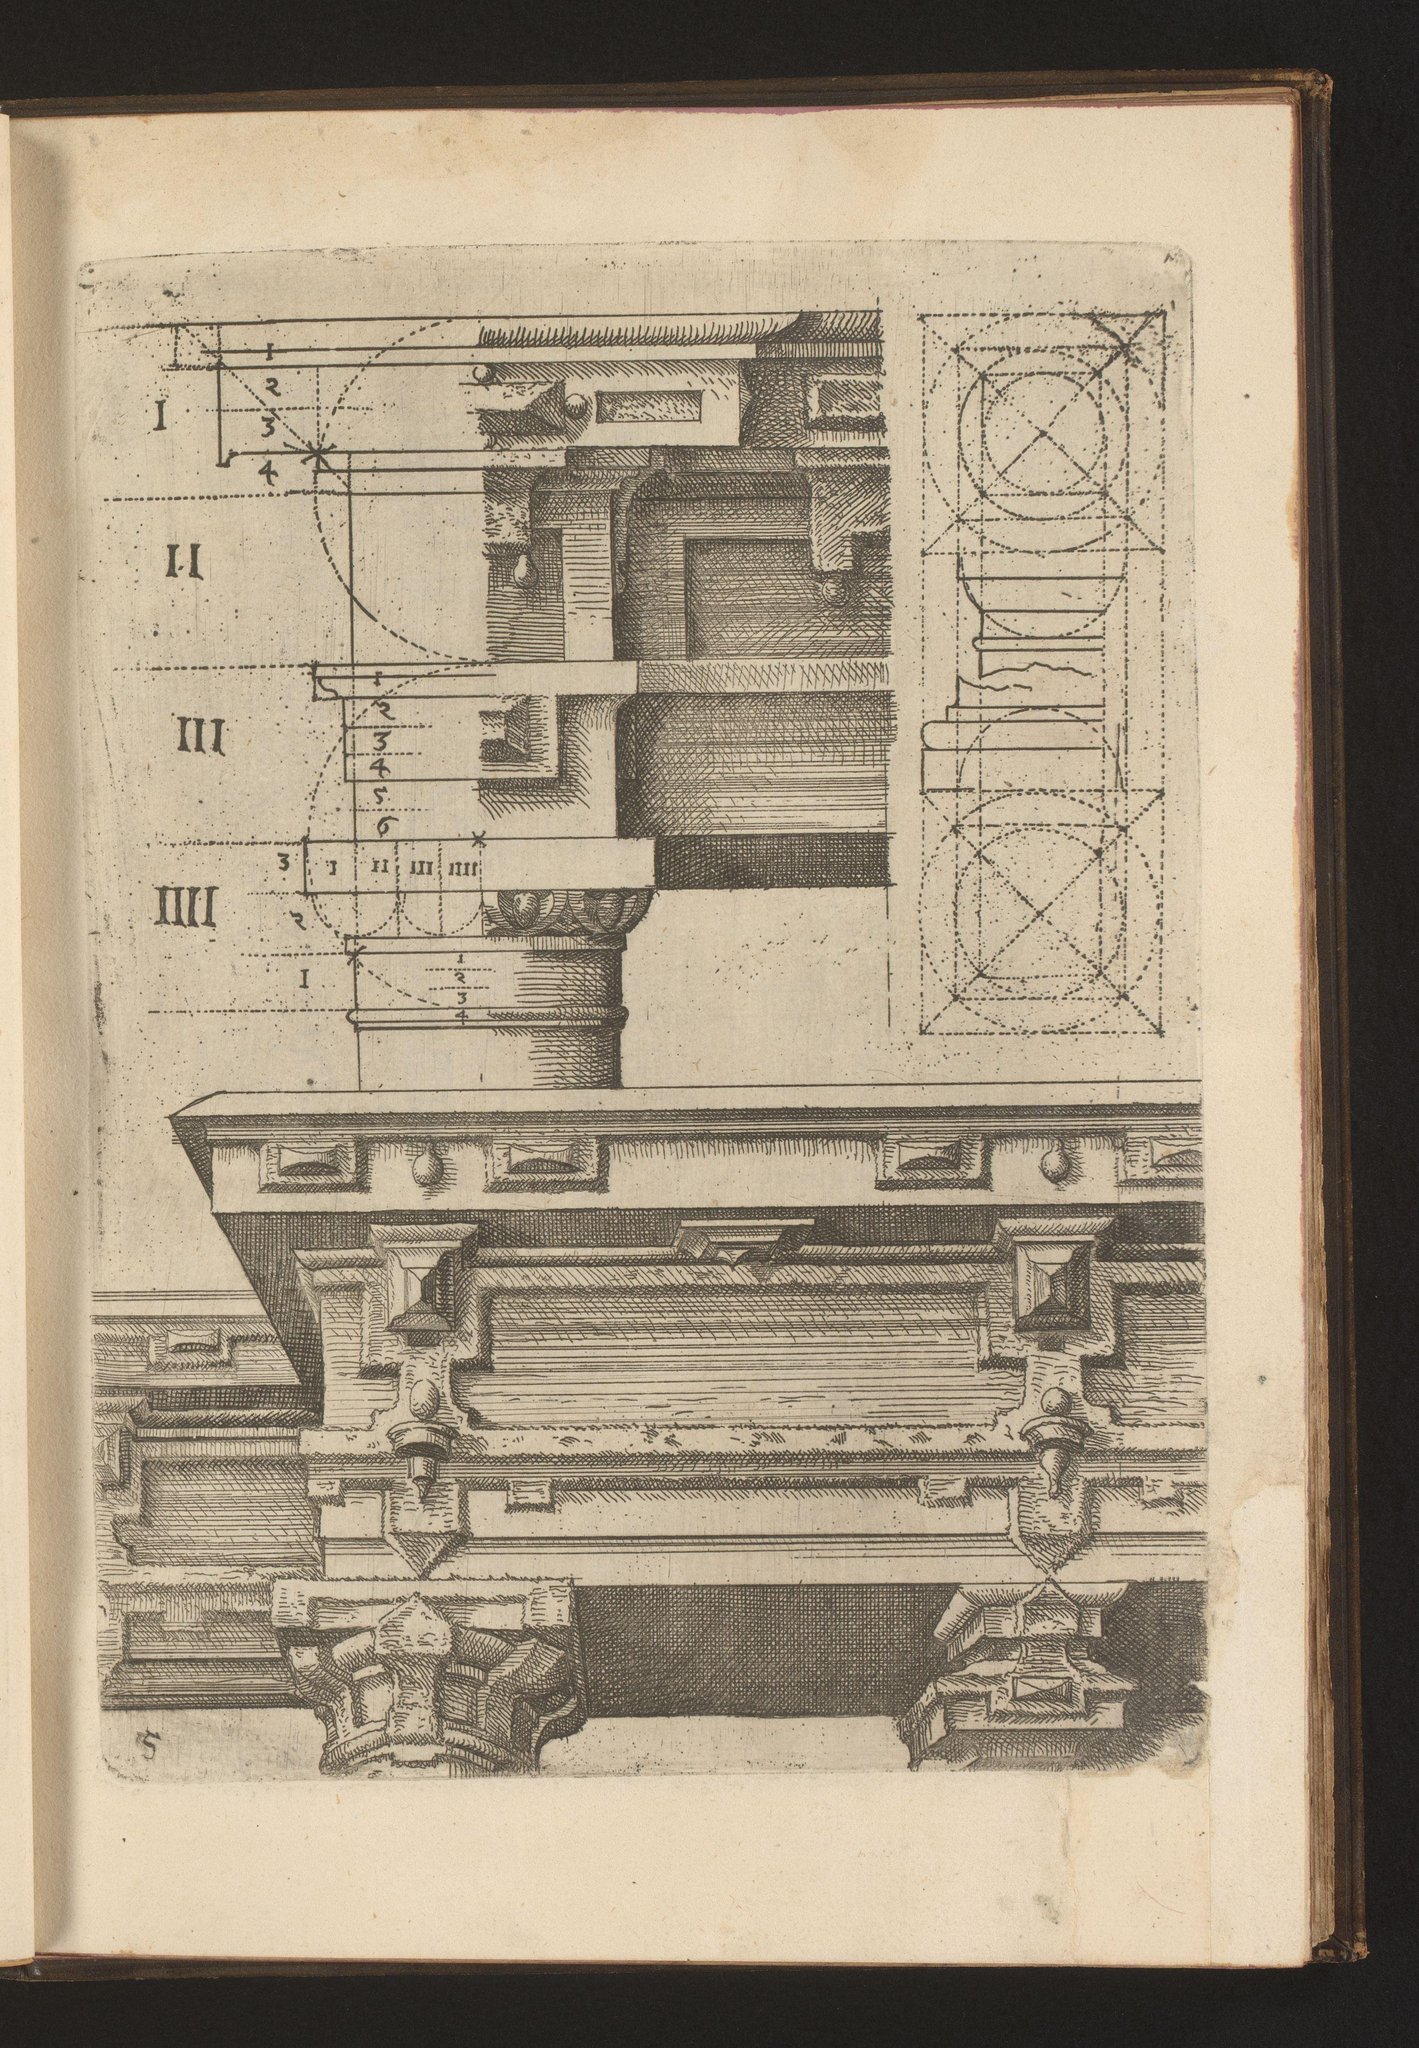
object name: book illustration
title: Verhoudingen van een hoofdgestel uit de Toscaanse orde en een detail van een hoofdgestel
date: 1593-1595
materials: paper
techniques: etching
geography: straatsburg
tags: column, pillar ~ architecture, tuscan order ~ architecture, other architectural details (entablature)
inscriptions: collector's mark: Lugt 2760, collector's mark: Lugt 2228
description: Prent gebruikt in: Dietterlin, Wendel (I). Architectura de quinq[ue] columnarum simmetrica distributione et variis eorundem or namentis: Liber I. Straatsburg: Bernhard Jobin, 1593.